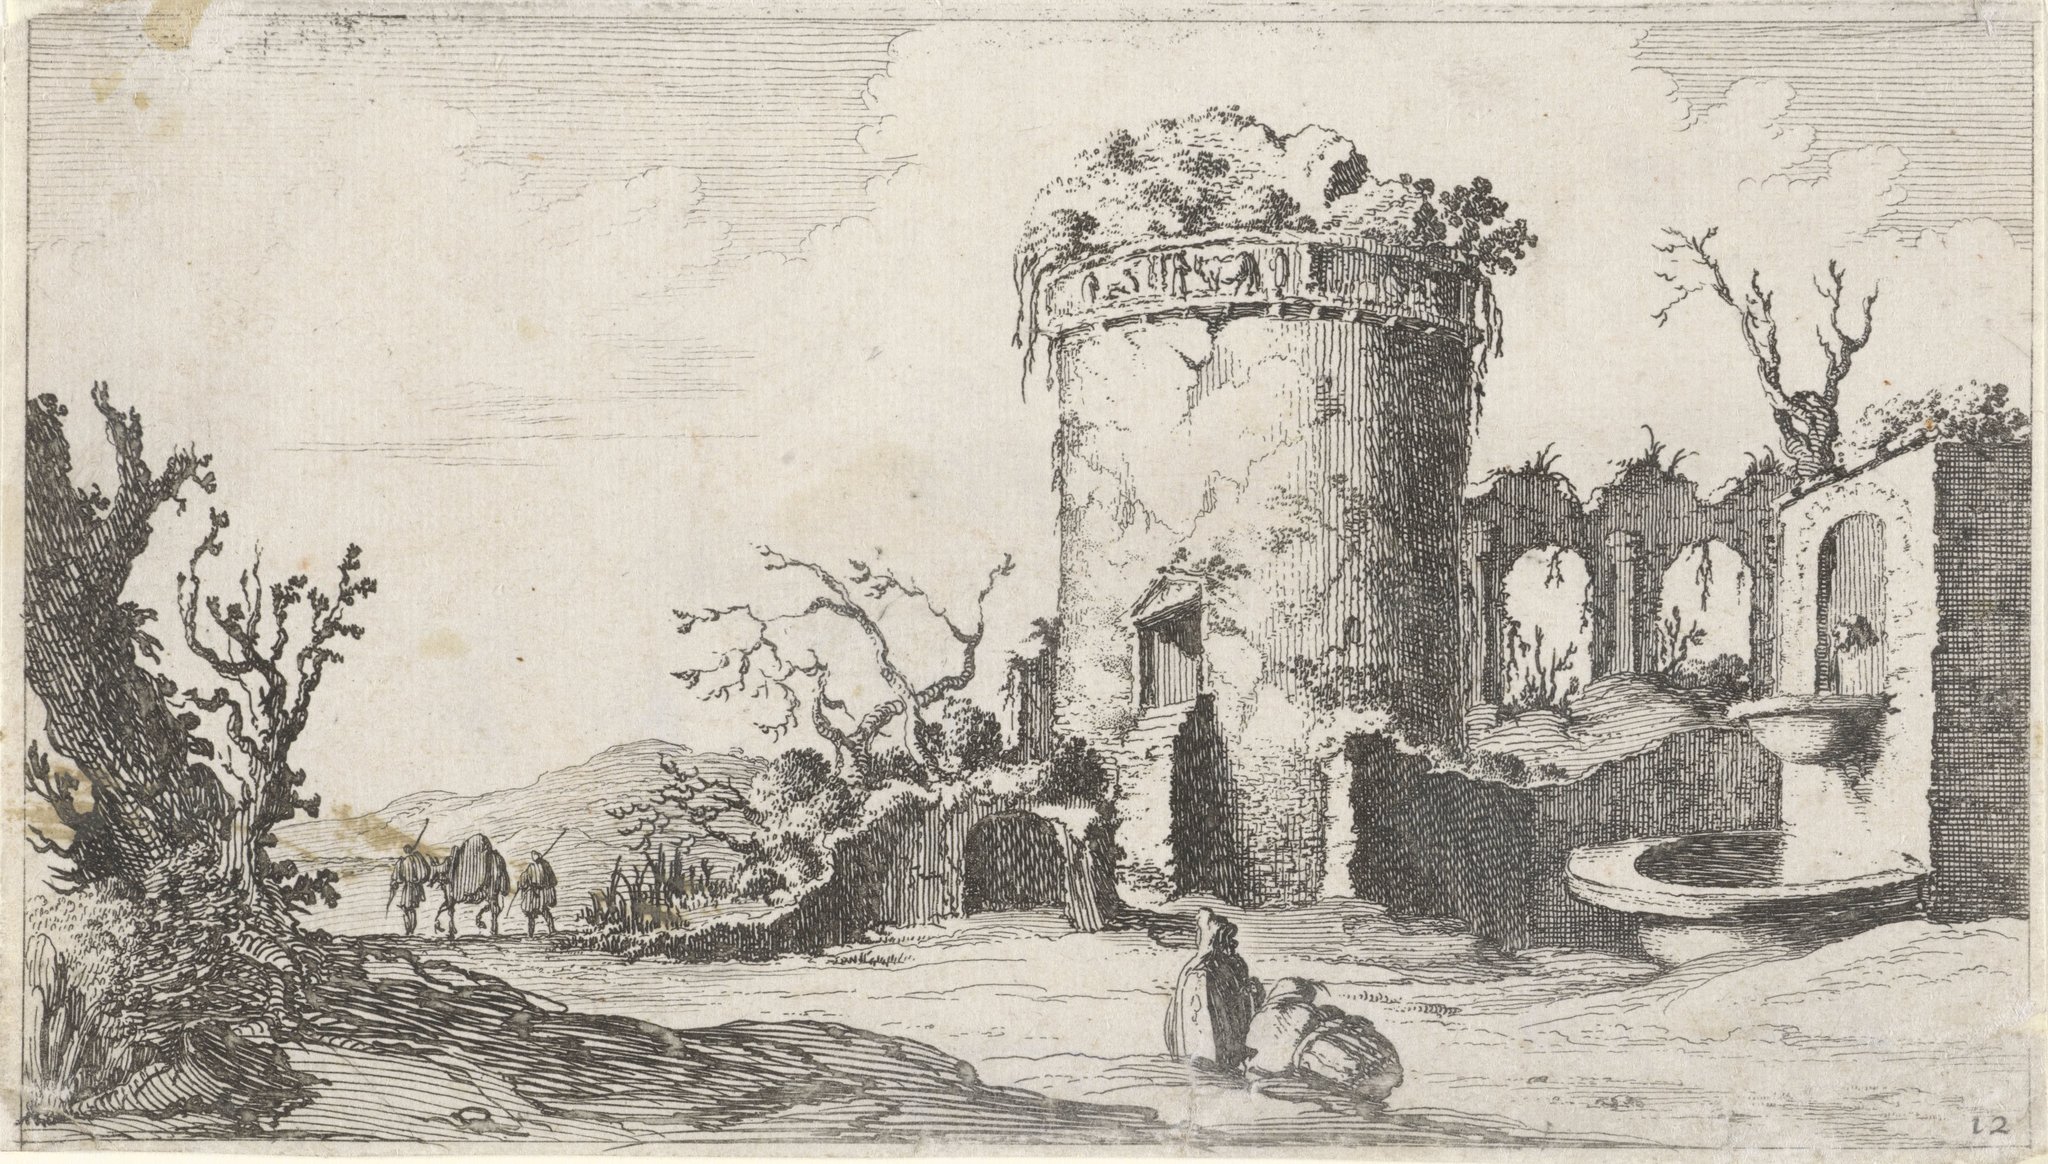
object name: print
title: Twaalf landschappen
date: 1605-1653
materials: paper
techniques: etching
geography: netherlands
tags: landscape with ruins, ornamental fountain, 'en route', traveller under way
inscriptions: collector's mark: Lugt 2228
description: In een landschap ligt een ruïne met een ronde toren en een fontein. Langs de ruïne trekken twee reizigers met een paard. Op de voorgrond zitten enige figuren naar de ruïne te kijken. De prent maakt deel uit van een serie van twaalf landschappen.